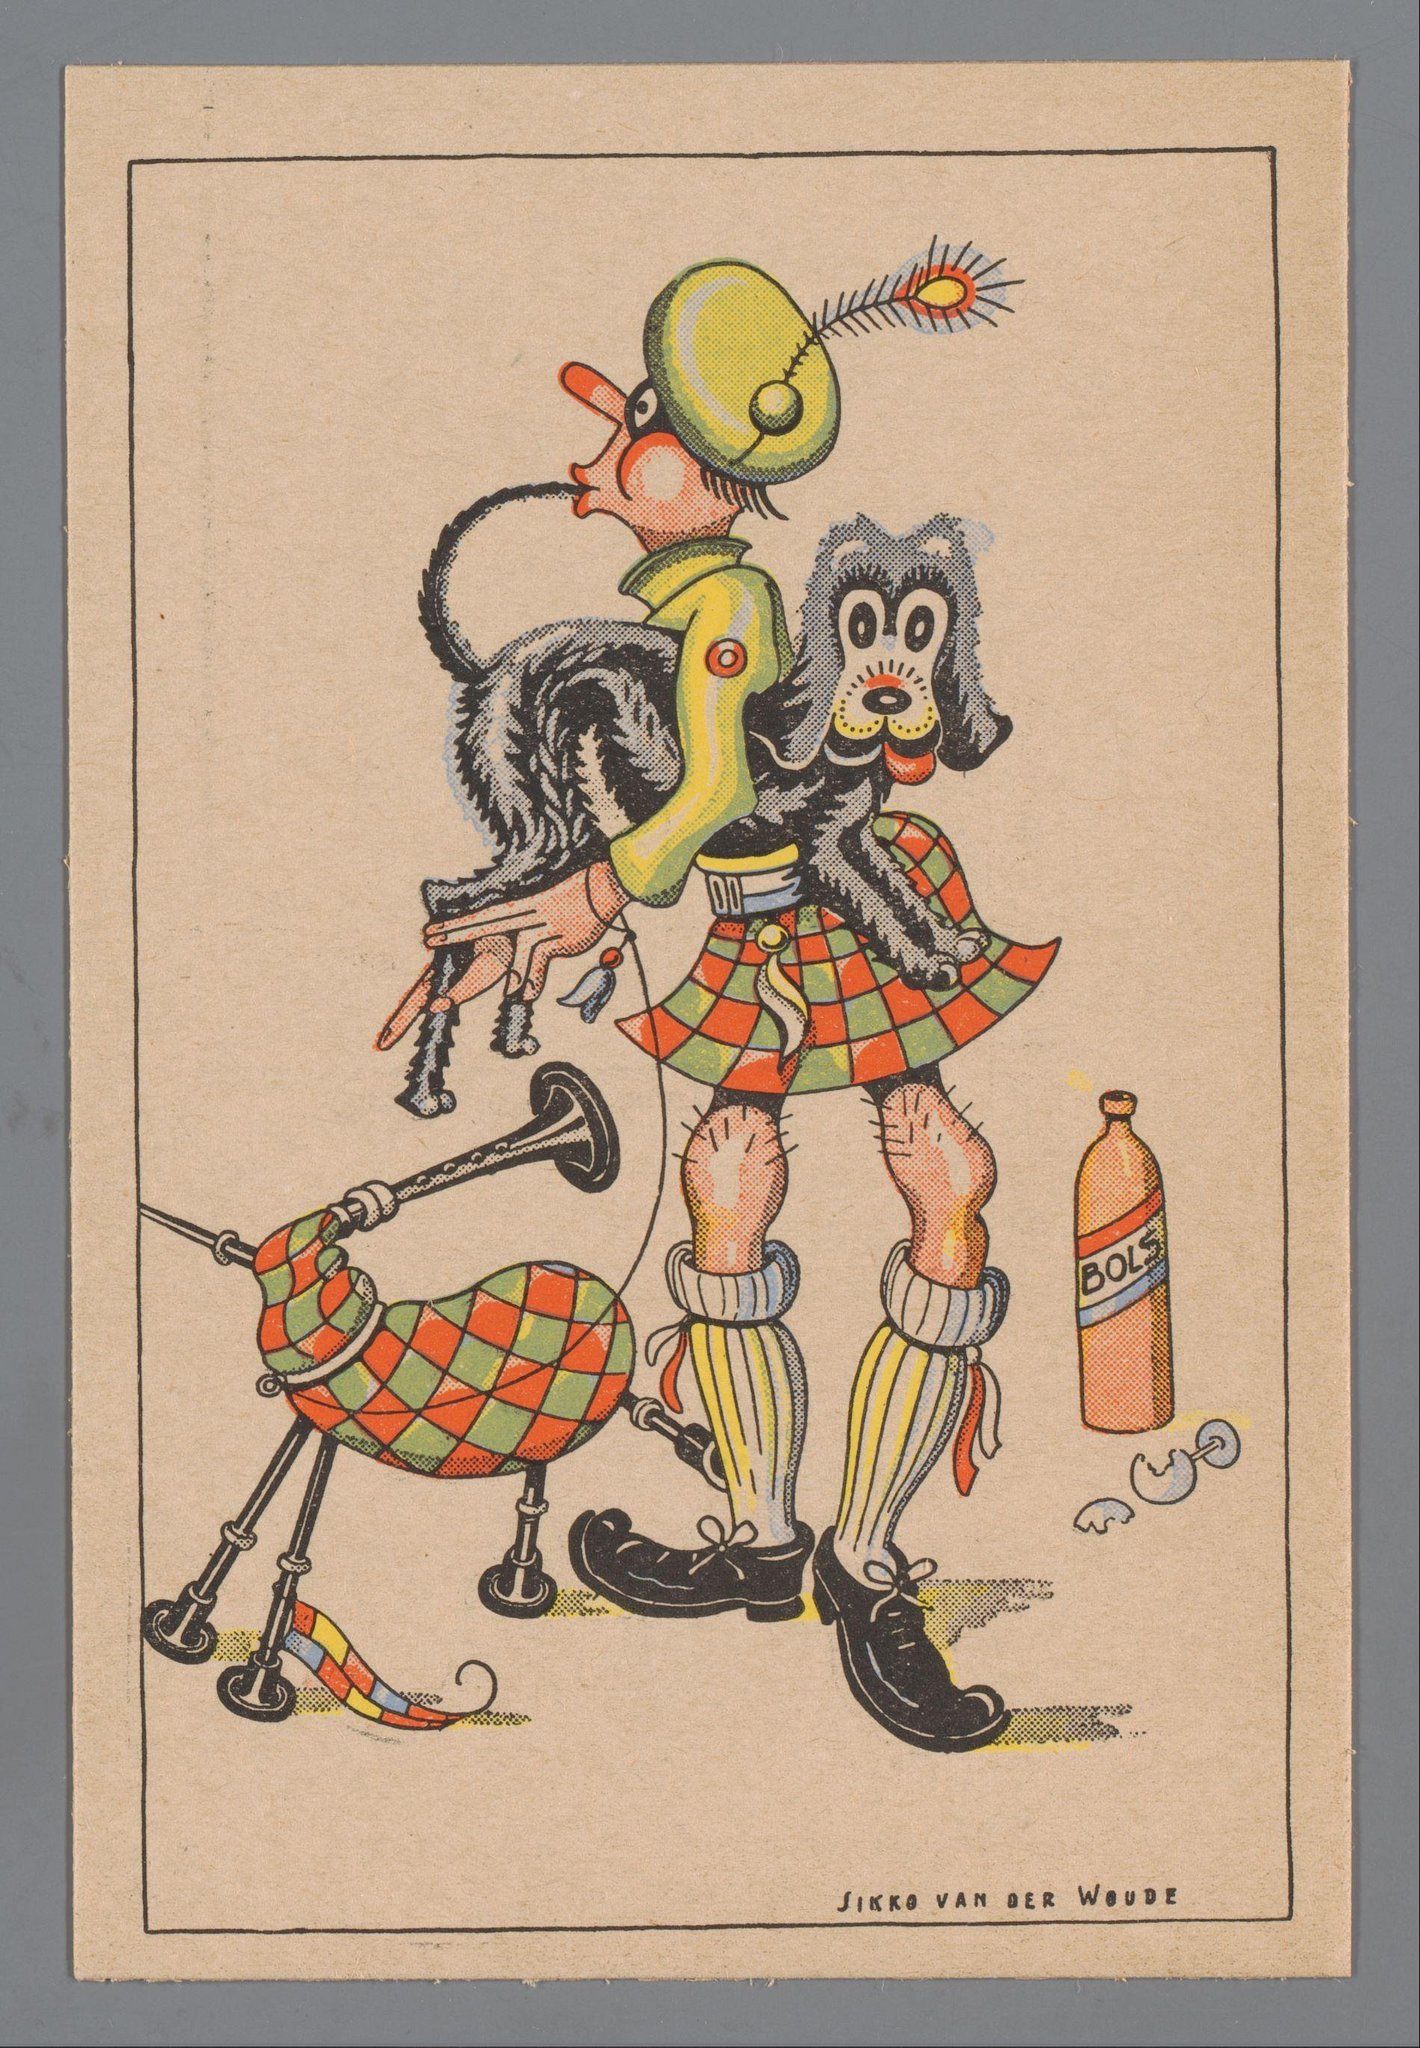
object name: postcard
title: Picture post card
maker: sima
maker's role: publisher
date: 1945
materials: paper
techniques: printing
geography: netherlands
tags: netherlands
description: Eén van acht 'grappige' prentbriefkaarten, tekeningen in kleur van in klederdracht gestoken Nederlanders en (meest schotse) soldaten. Opmerking: Acht briefkaarten in envelop met tekst in rood en blauw in rood-wit-blauw kader.